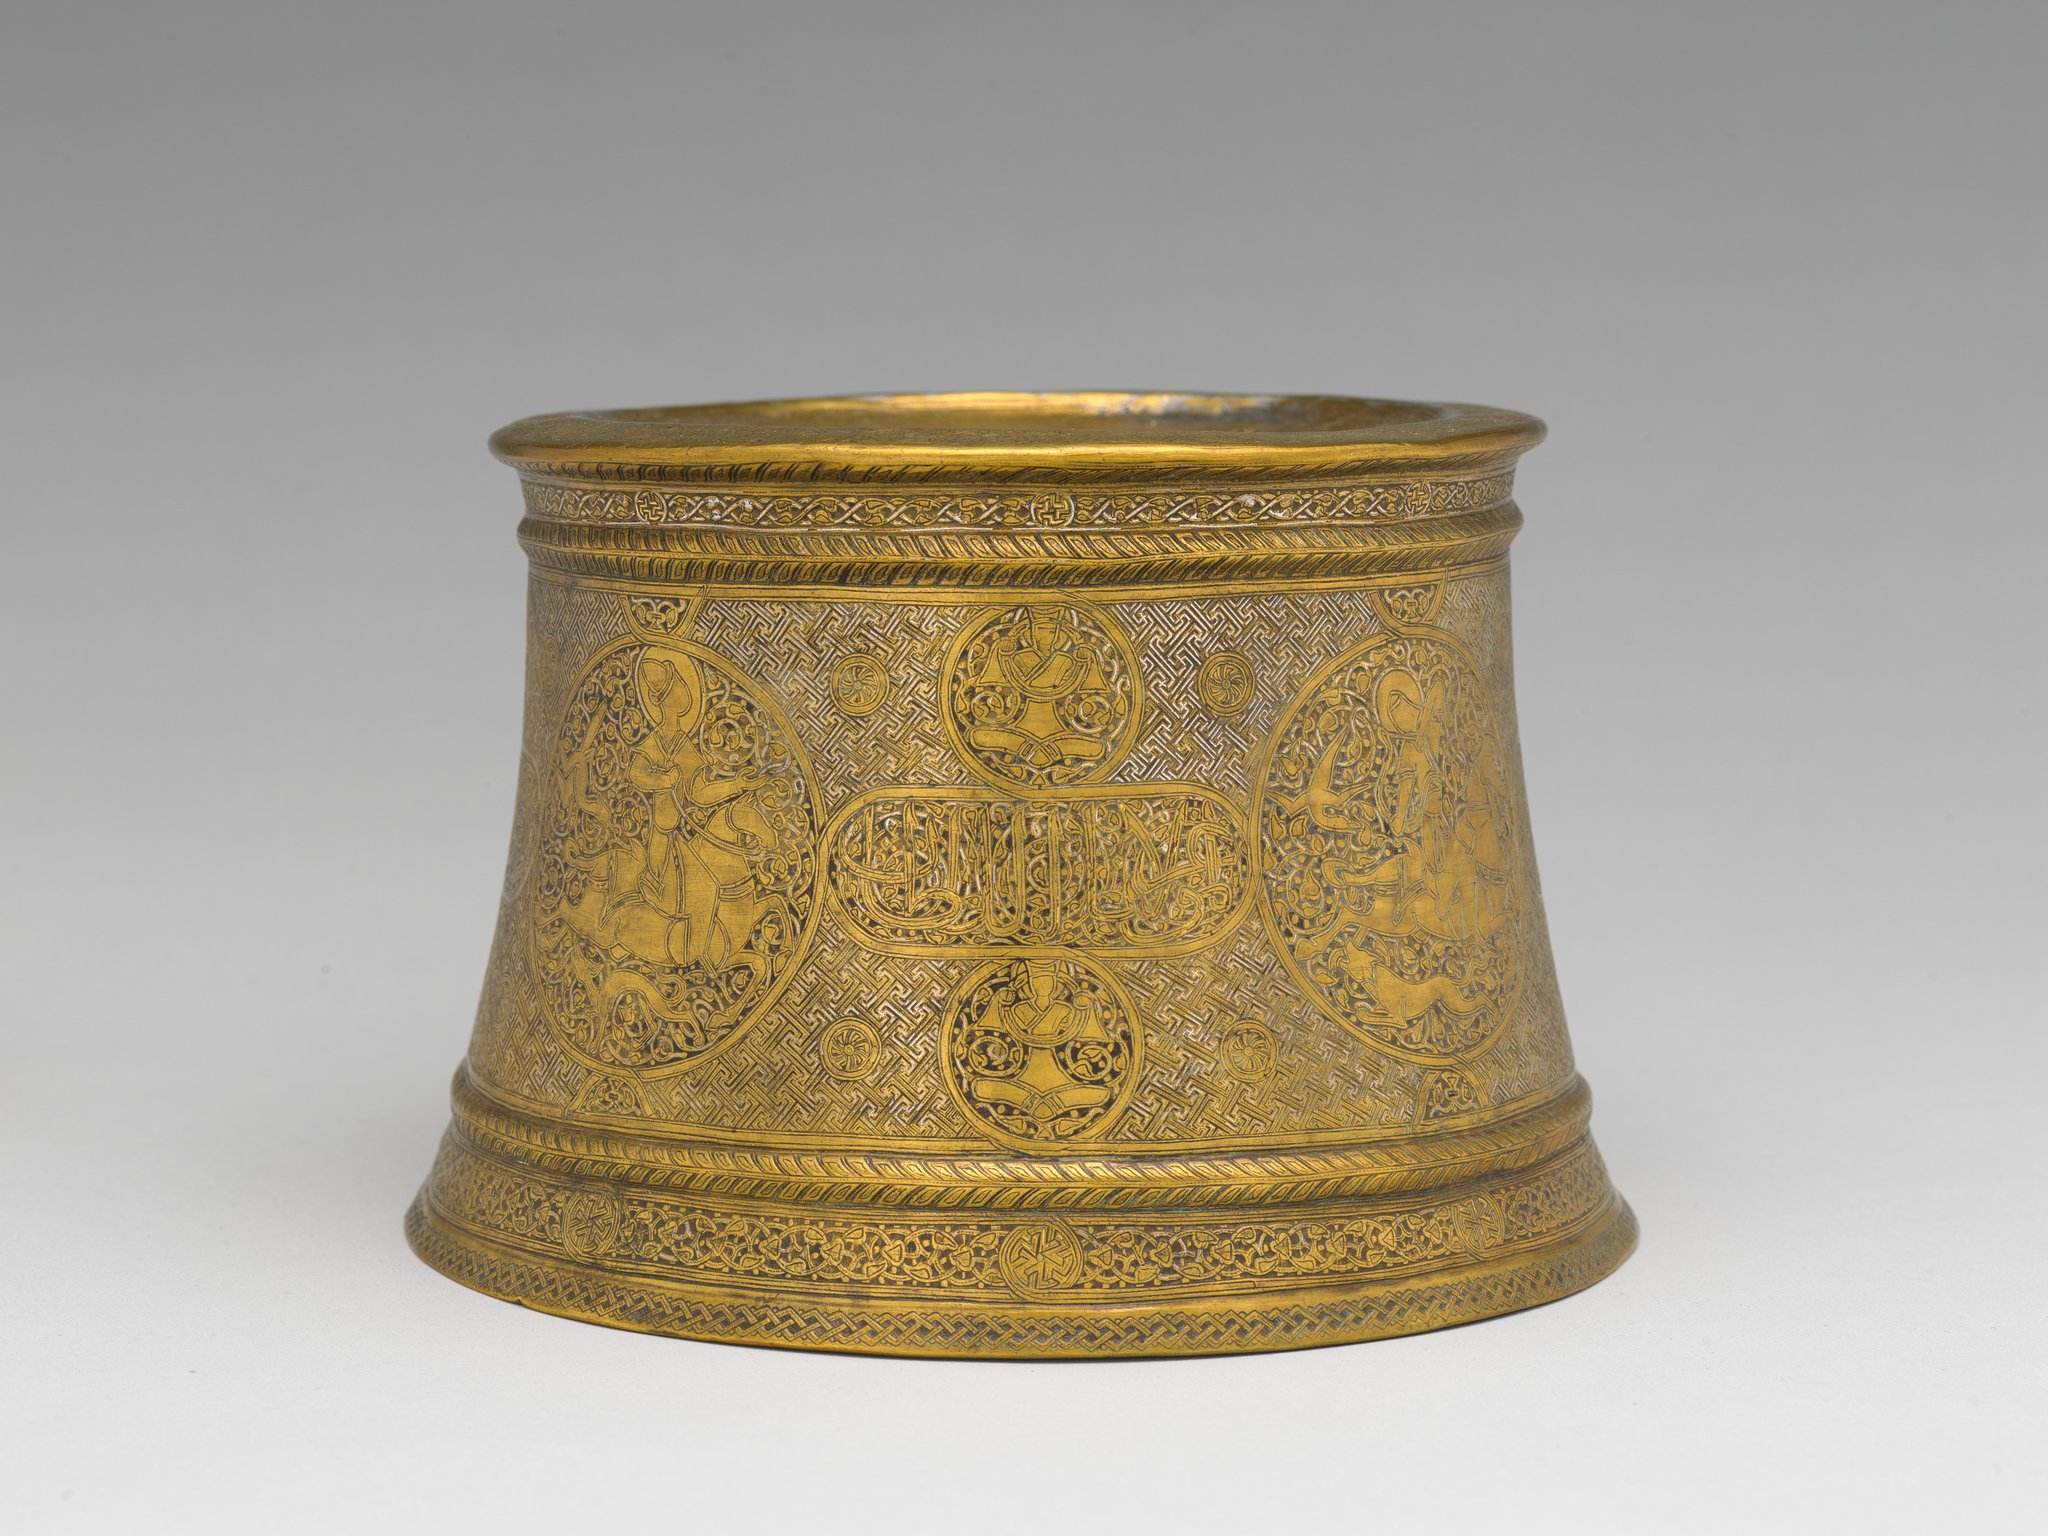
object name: candlestick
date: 1301-1350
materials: brass, silver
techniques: engraving, inlay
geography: egypt or syria